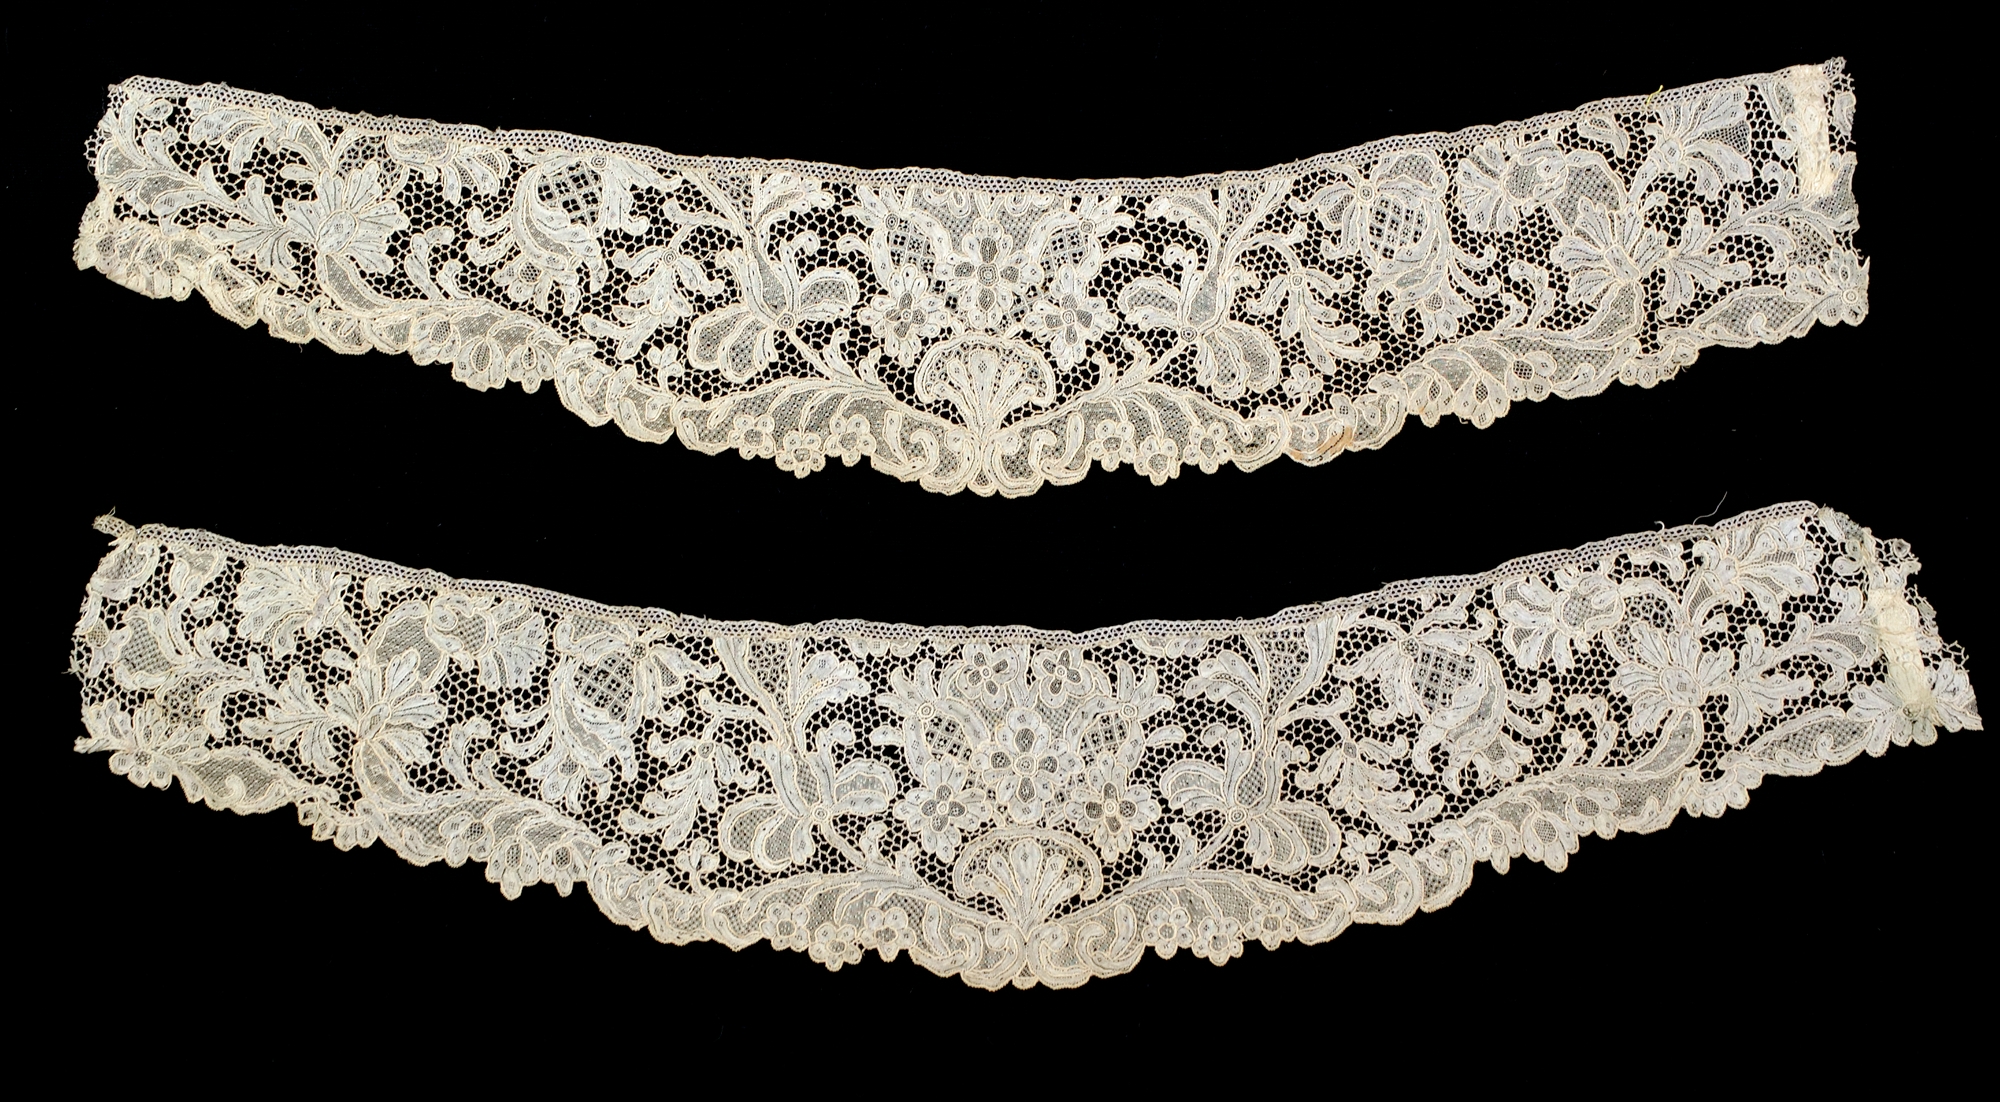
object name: cuff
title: Cuffs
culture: french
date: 1734-1766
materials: linen